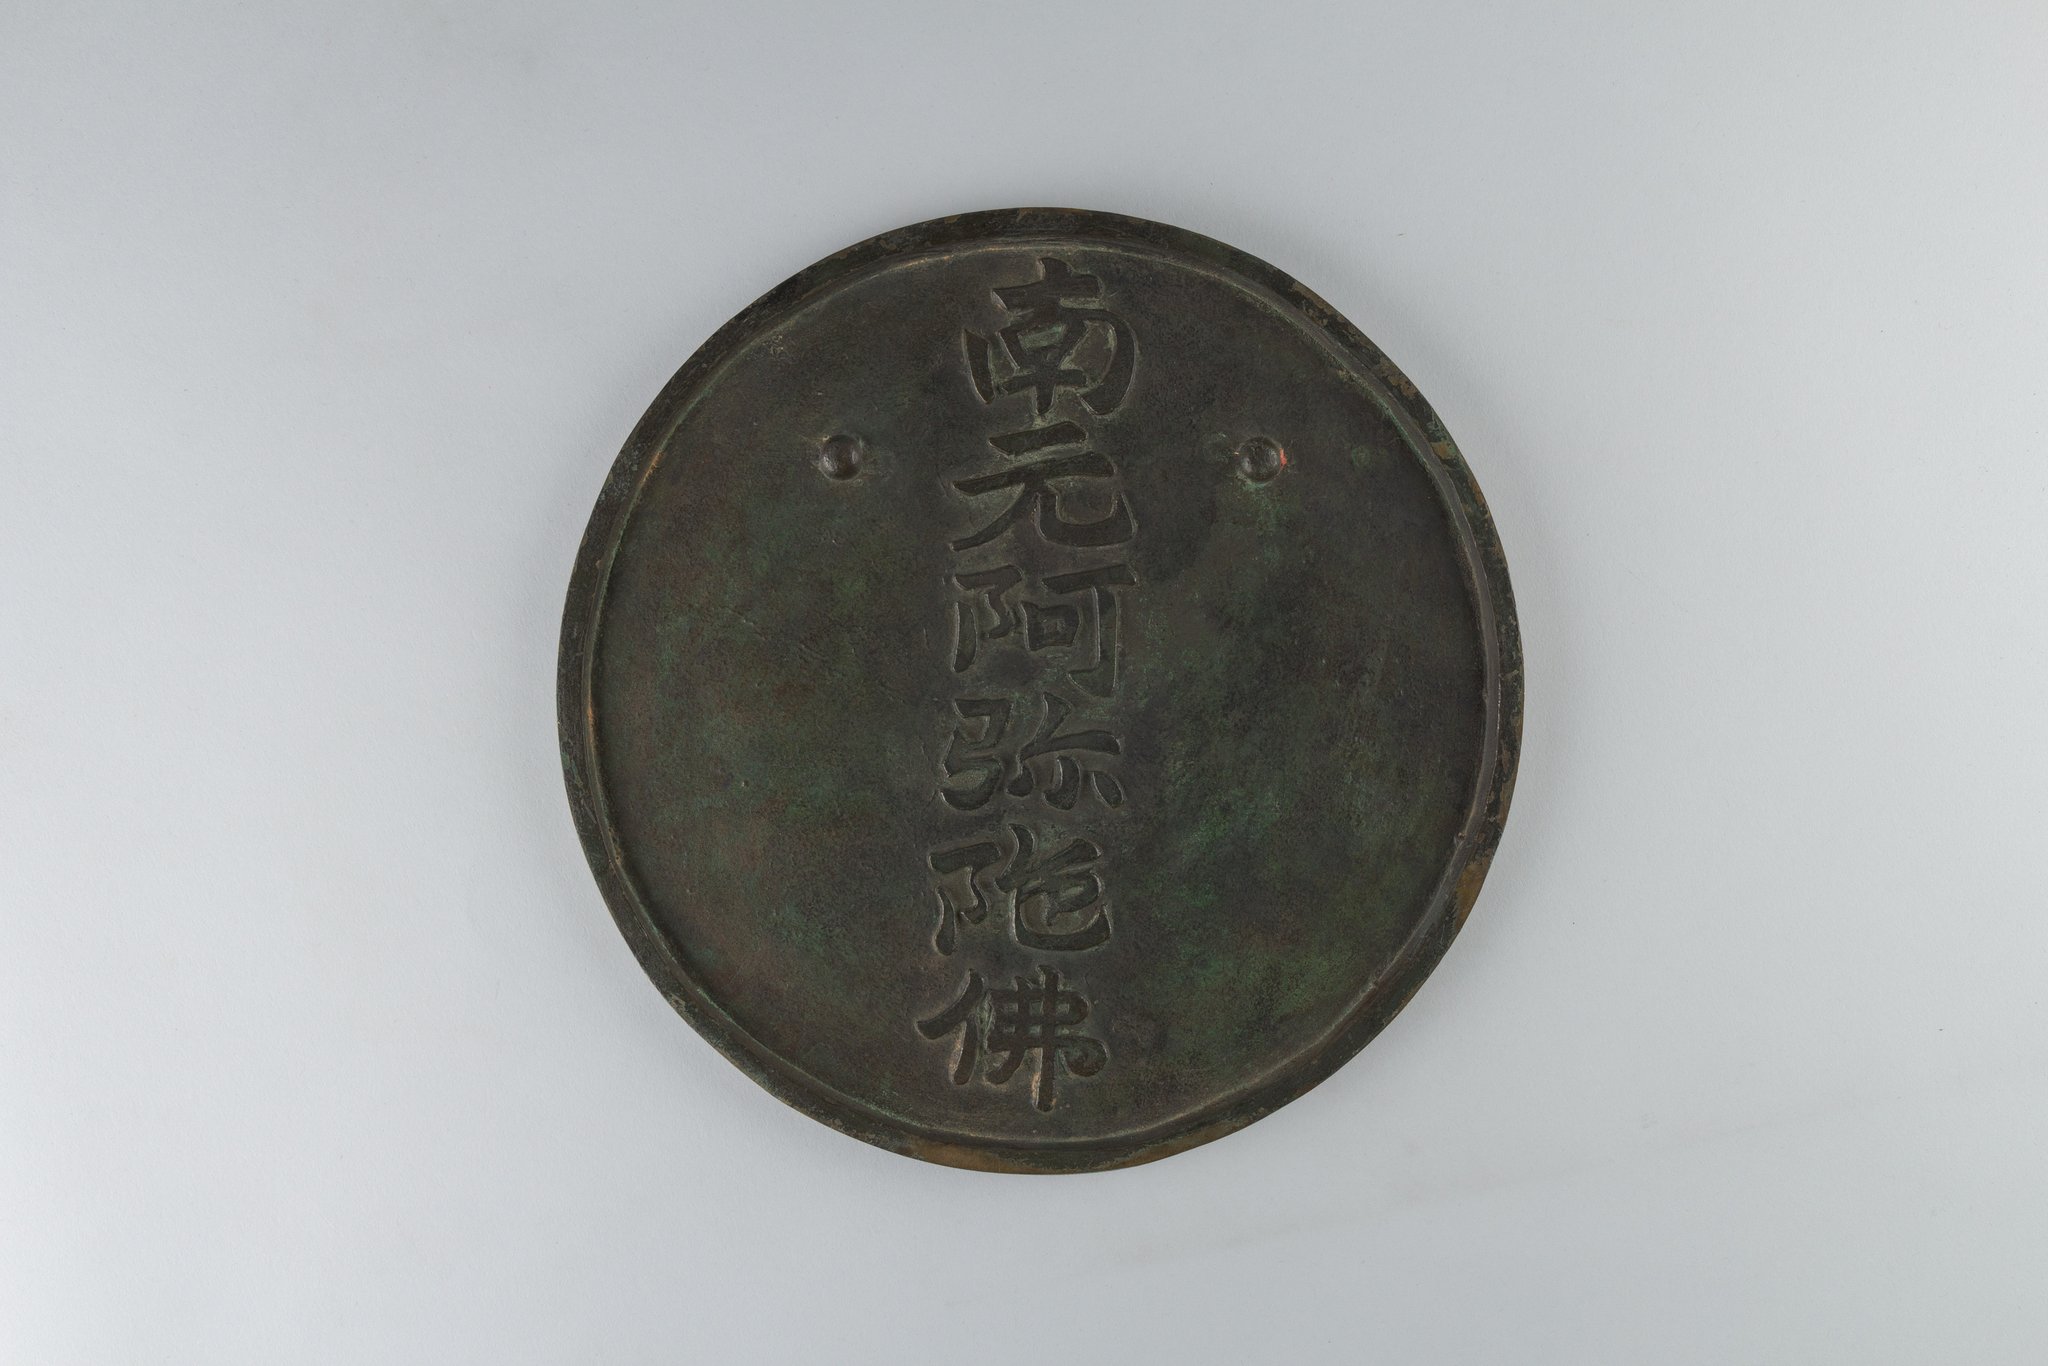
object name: mirror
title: Magic Mirror with Image of the Buddha Amida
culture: japanese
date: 1801-1900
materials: bronze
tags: buddha